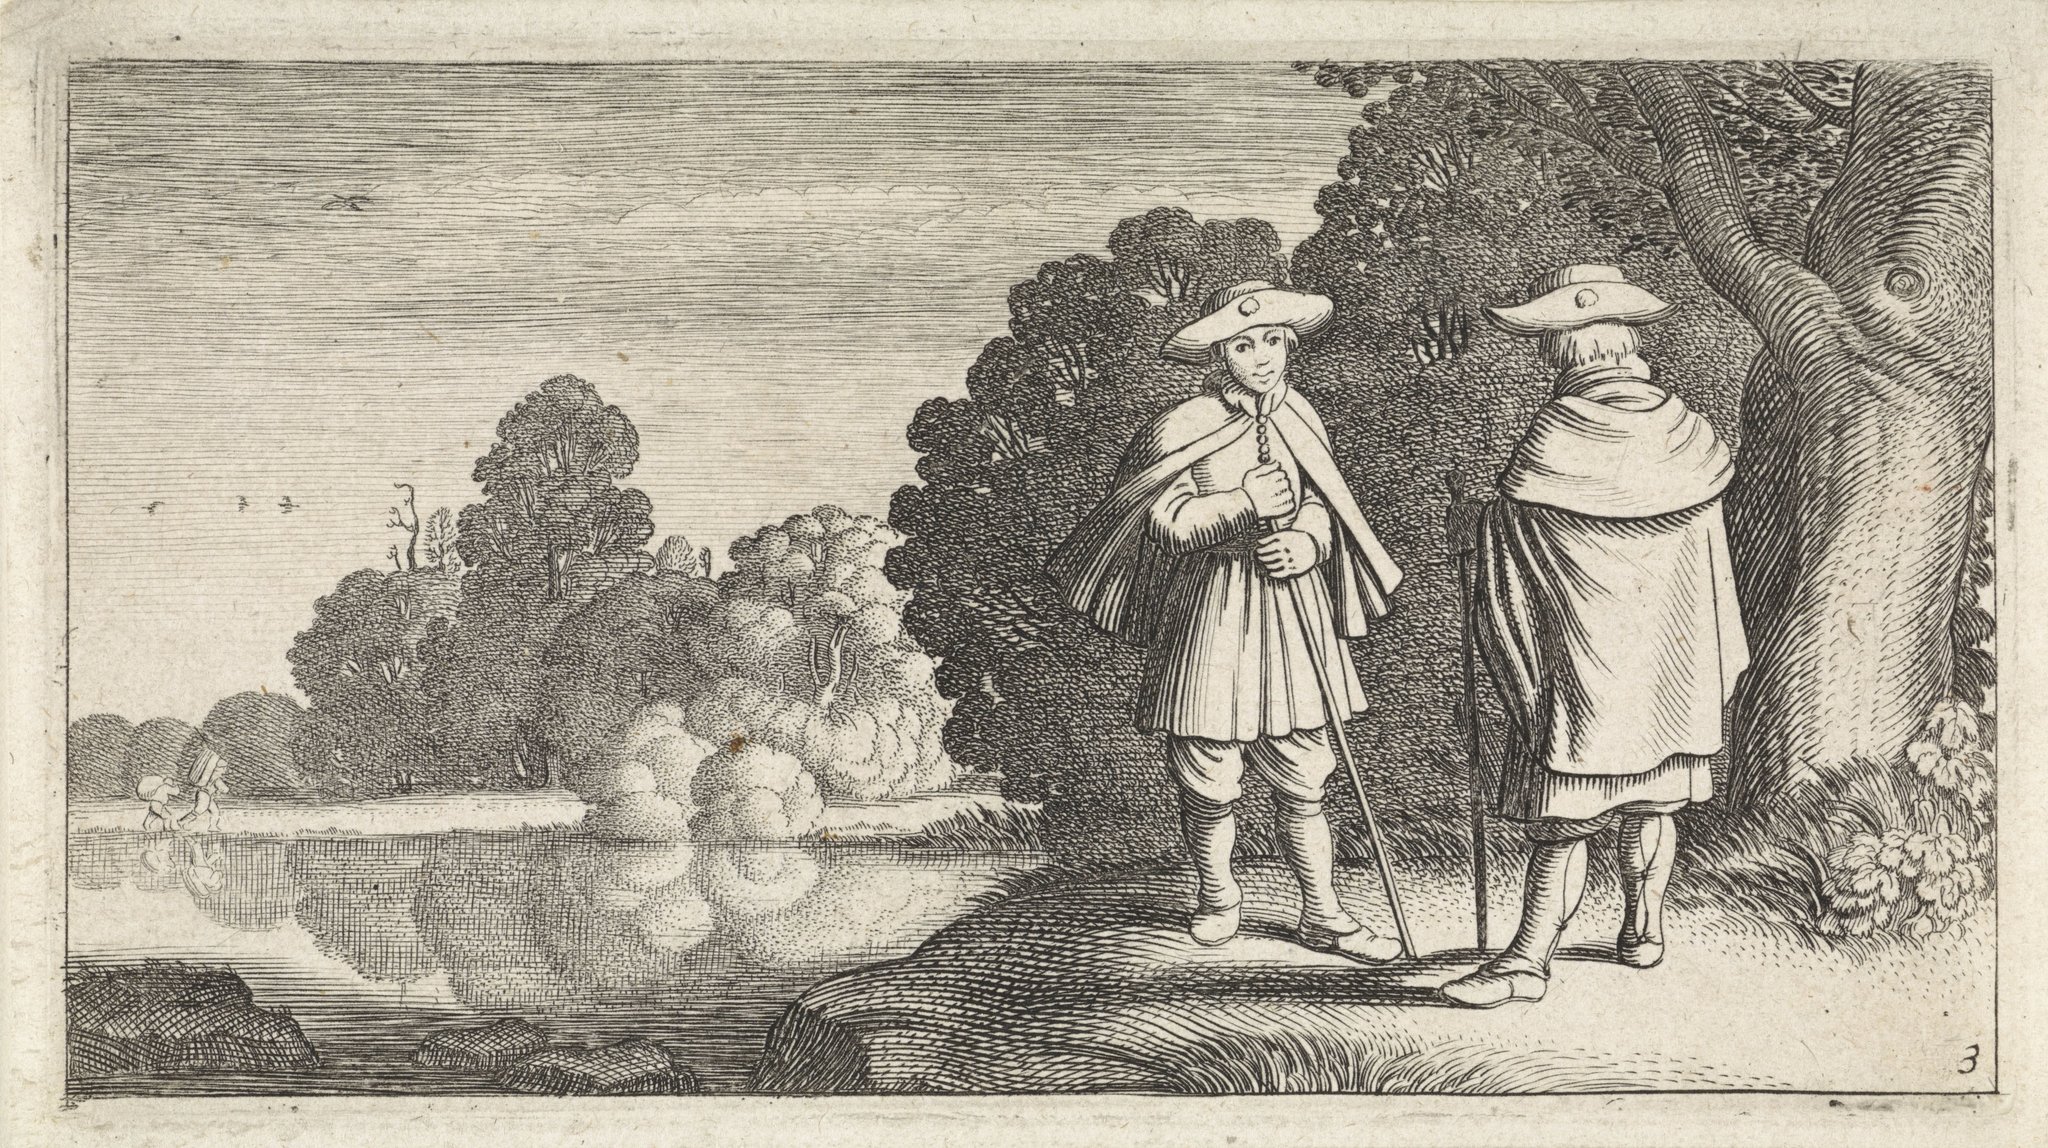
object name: print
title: Twee pelgrims bij een vijver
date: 1603-1652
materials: paper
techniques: engraving, etching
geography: northern netherlands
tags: pilgrim(s), lake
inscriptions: collector's mark: Lugt 964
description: Twee pelgrims aan de rand van een meer, waarvan een op de rug gezien. Op de achtergrond twee figuren met manden op hun rug. Derde prent uit een serie van zes.